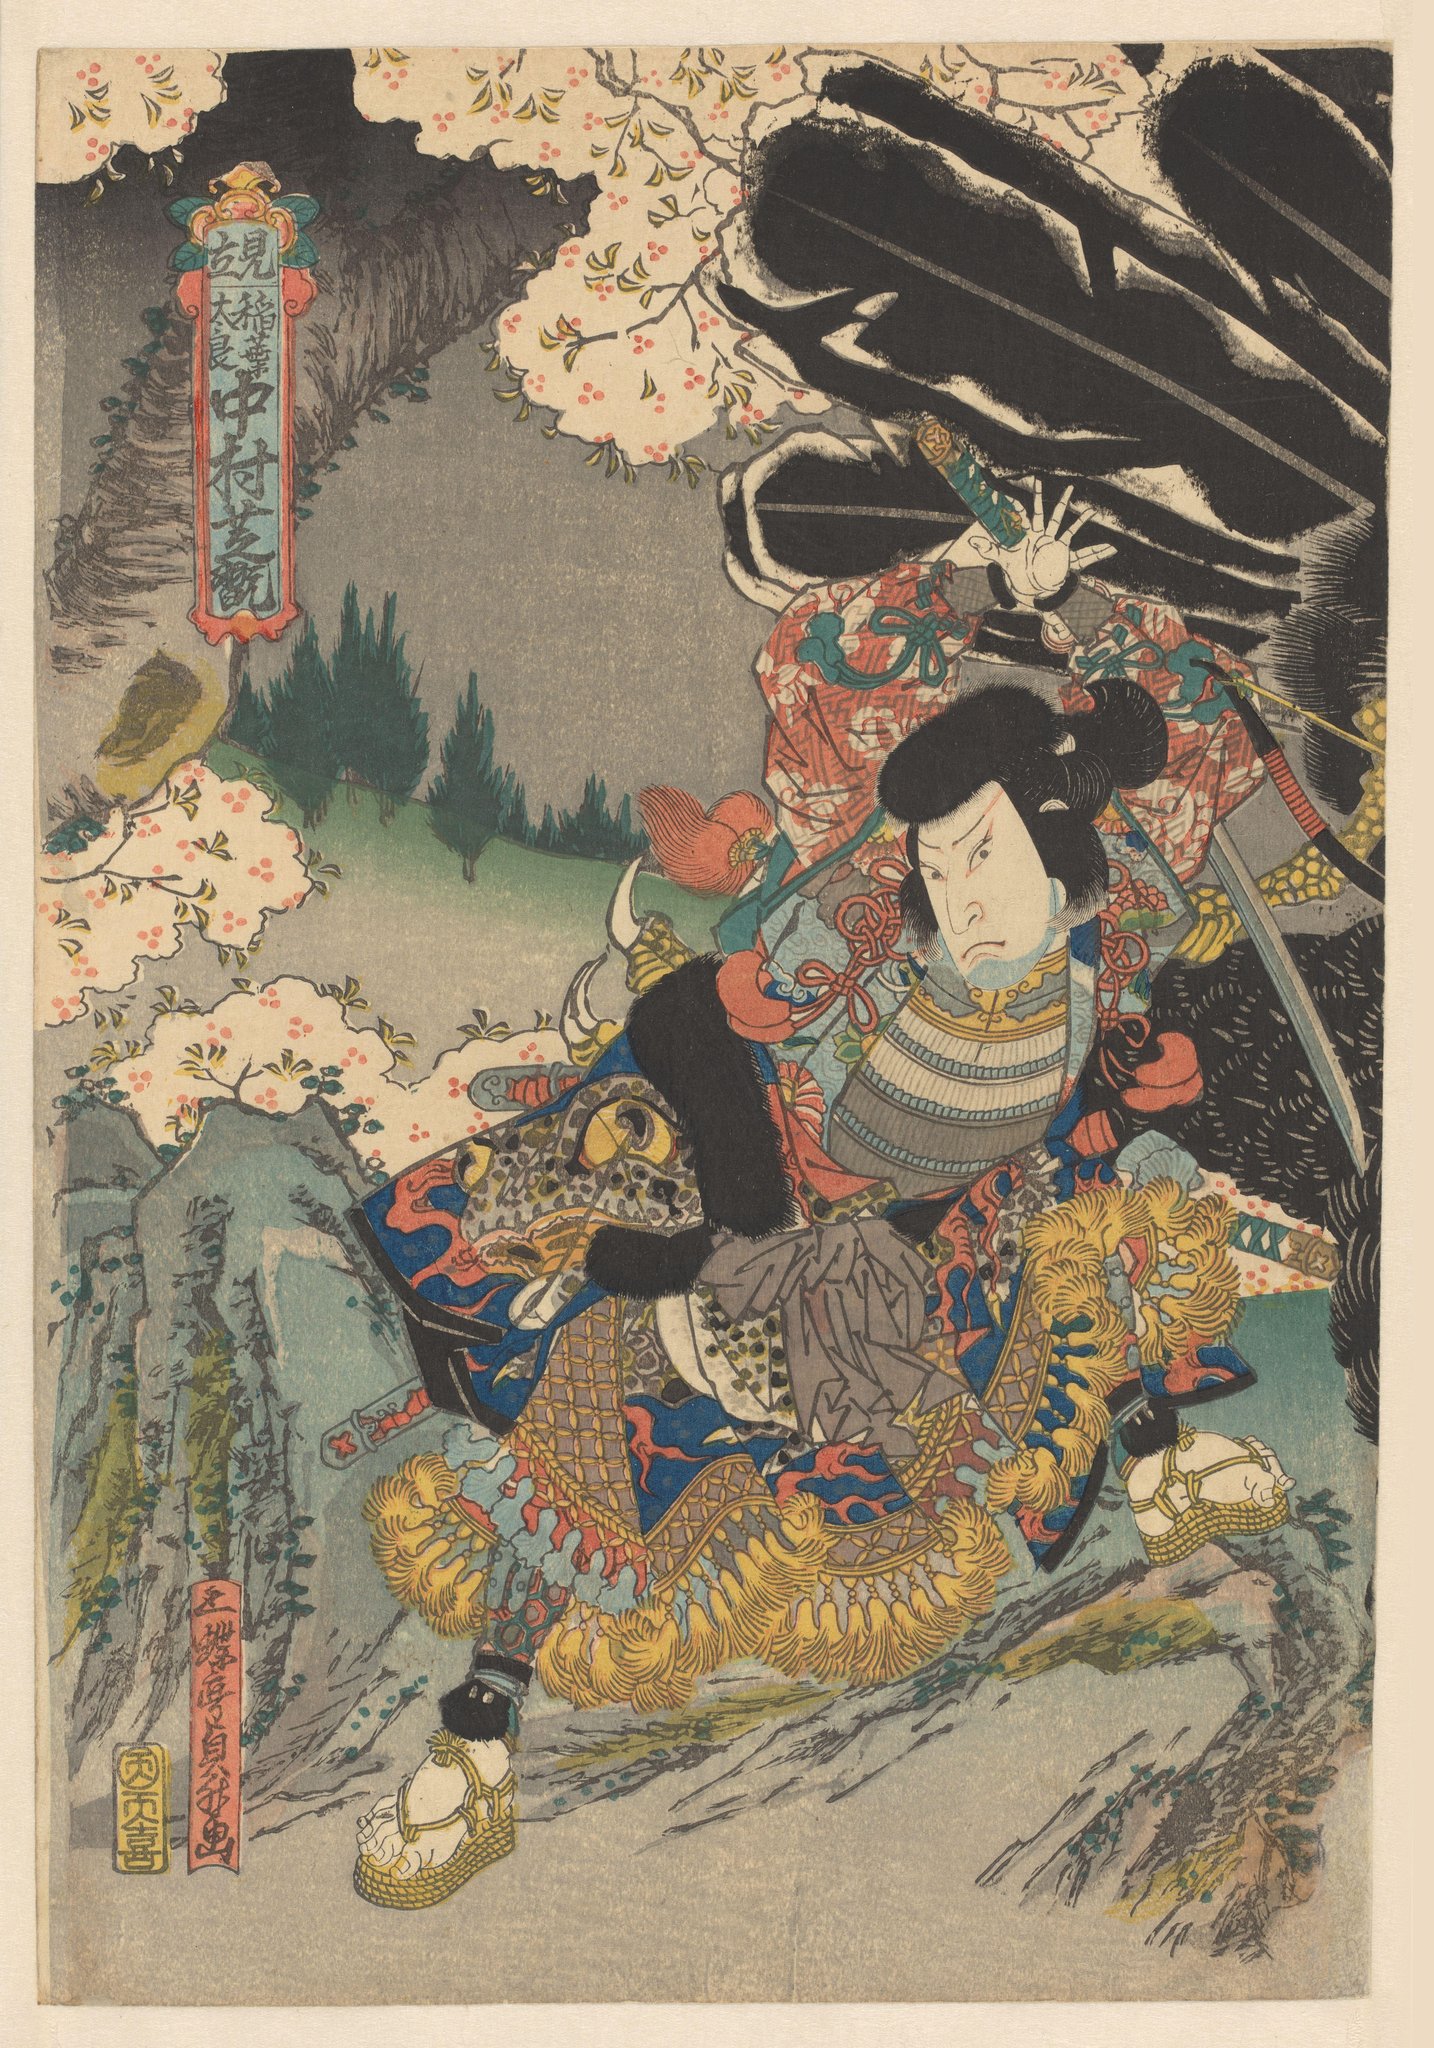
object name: print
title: Vierluik met vier toneelspelers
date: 1834-1835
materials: paper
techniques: woodcut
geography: japan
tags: japan, adult man, hacking and thrusting weapons: sword, landscapes (+ landscape with figures, staffage)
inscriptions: signature: ‘Gochôtei Sadamasu ga’, mark: ‘Tenki’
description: Tweede blad van links van een vierluik v.l.n.r. Iwai Shijaku I als Inaba, Nakamura Shikan II als Inaba Tarô, Arashi Rikan II als Ushiwaka Saburô, en Nakamura Baigyoku I (Nakamura Utaemon III) als Tsujikaze Happei. In het midden van de scène ligt een reusachtige, overwonnen roofvogel.